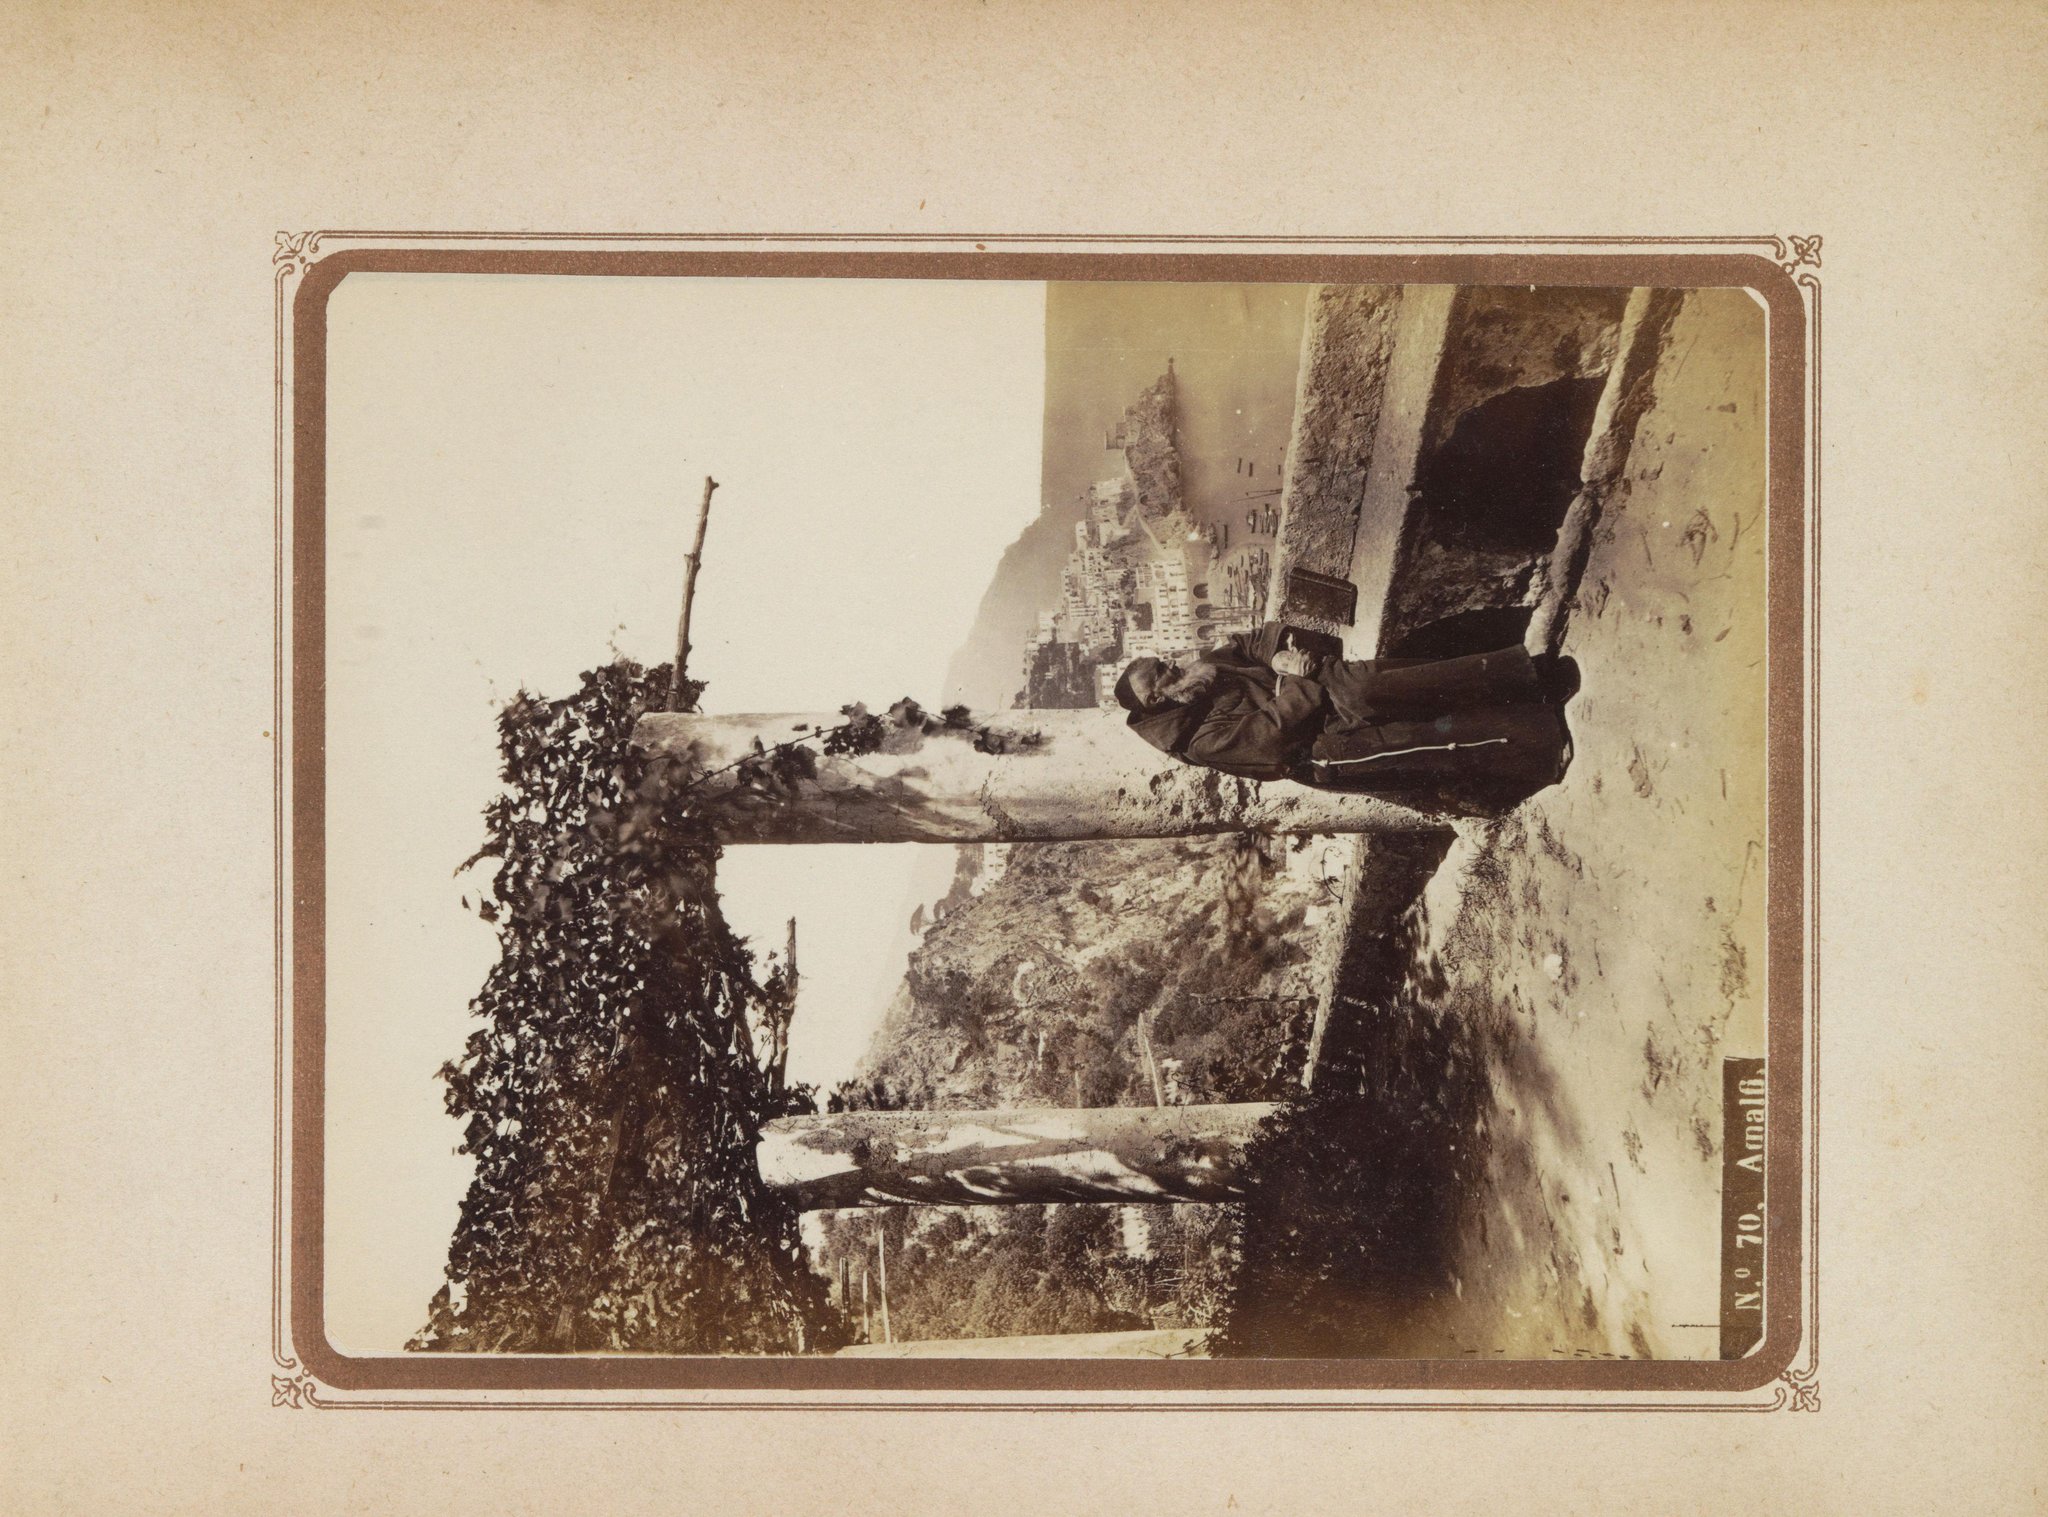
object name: album leaf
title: Gezicht op Amalfi vanuit een klooster, op de voorgrond een kapucijnermonnik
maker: roberto rive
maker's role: fotograaf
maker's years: 1825-1868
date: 1860-1900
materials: paper, photographic support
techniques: albumen print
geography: amalfi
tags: prospect of village, silhouette of village, monk(s), friar(s), amalfi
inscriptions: number: ‘70’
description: Onderdeel van Fotoalbum met bezienswaardigheden in Napels en omgeving door Roberto Rive.